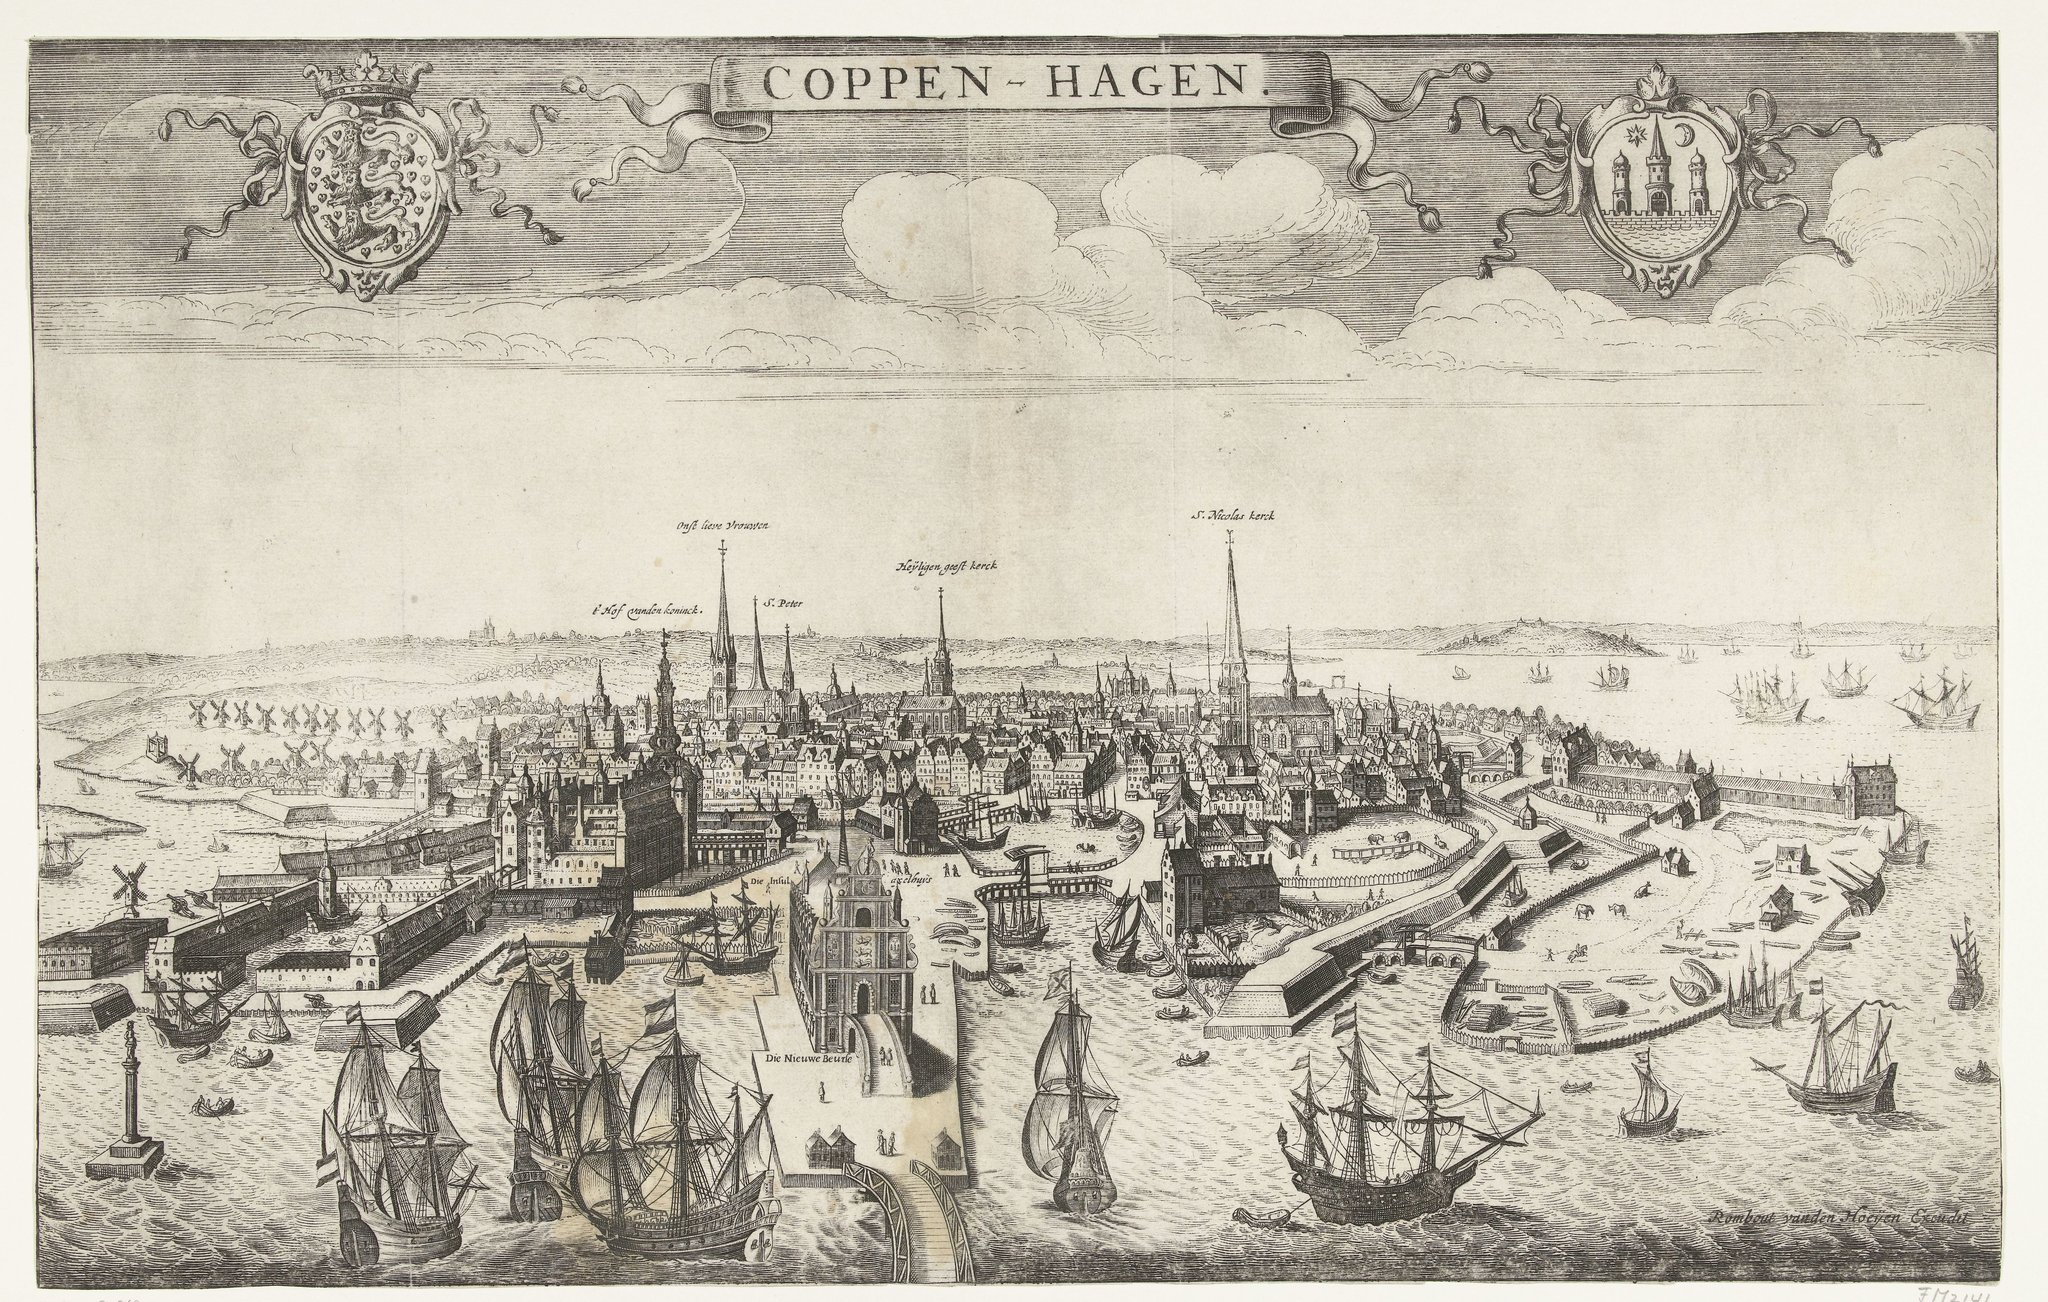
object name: print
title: Coppen-hagen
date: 1659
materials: paper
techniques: engraving, etching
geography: amsterdam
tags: copenhagen (city)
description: Gezicht op Kopenhagen in vogelvluchtperspectief. Op de voorgrond schepen voor de haven en de nieuwe beurs. Bovenaan de wapens van Denemarken en Kopenhagen. Waarschijnlijk vervaardigd in verband met de Hollandse steun in februari 1659 aan het ontzet van Kopenhagen, belegerd door de Zweden.